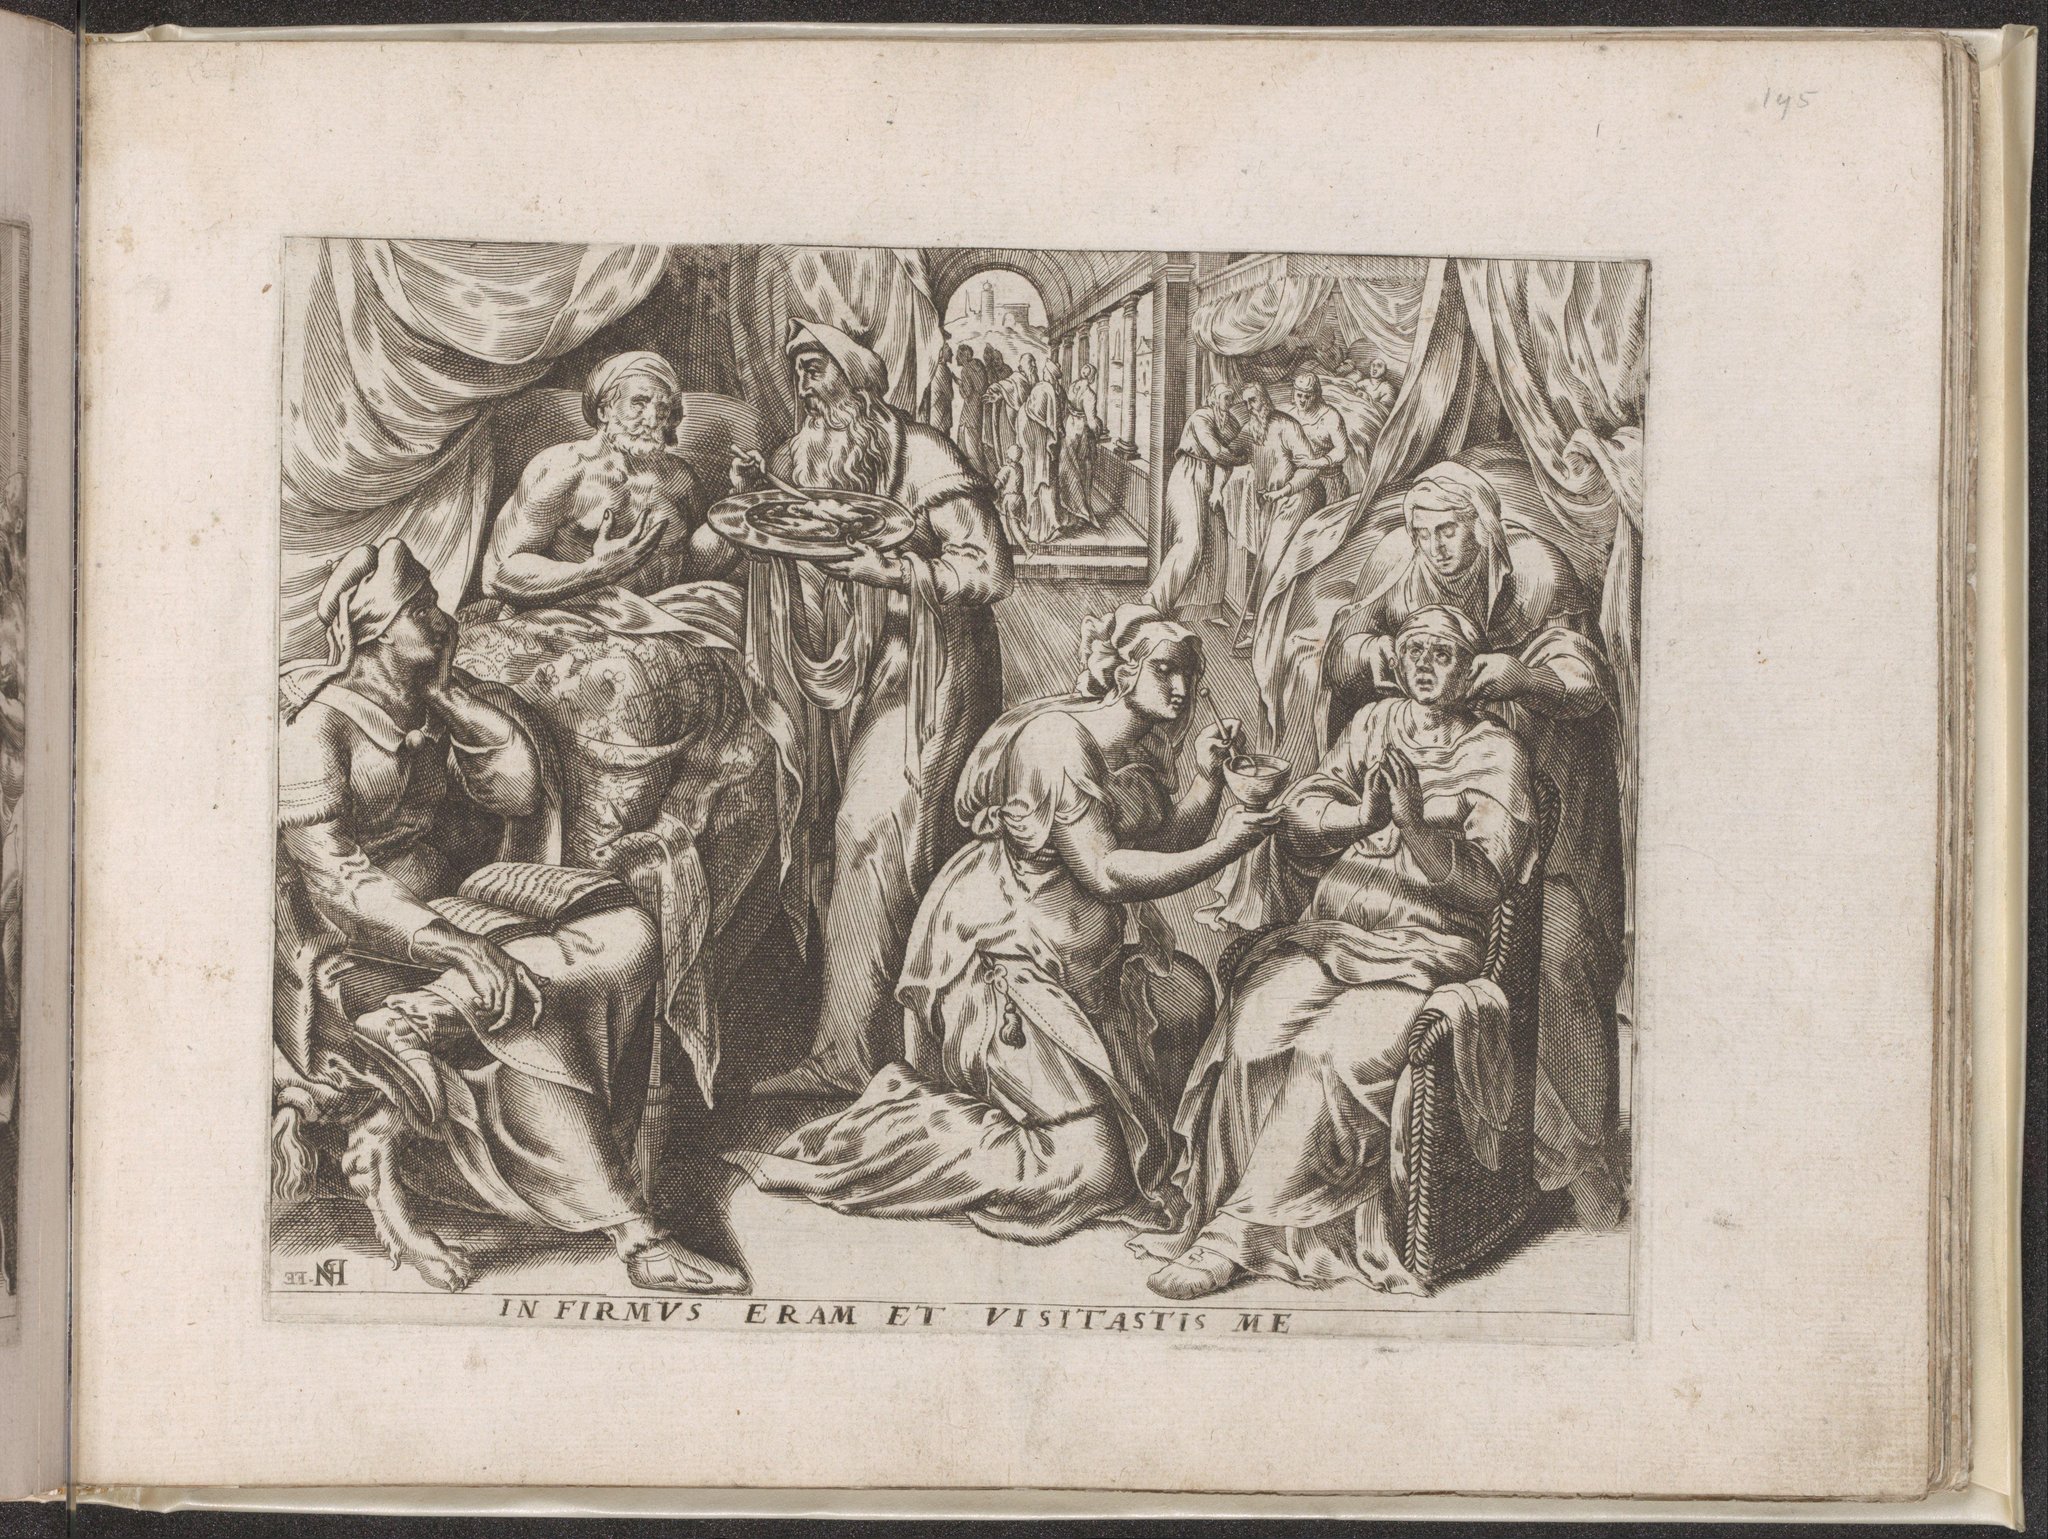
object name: album leaf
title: Bezoeken van de zieken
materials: paper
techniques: engraving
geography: antwerp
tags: hospital, visiting the sick, 'aeger curatur' ~ one of the (seven) acts of mercy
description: Het bezoeken en verzorgen van de zieken. In een gang met aan weerszijden bedden liggen de zieken. Links wordt een zieke voedsel aangeboden. Linksvoor zit een man met een boek op zijn schoot. Rechts zorgen twee vrouwen voor een zieke vrouw, die op een stoel zit. Onder de voorstelling een verklarende tekst in het Latijn. Deze prent maakt deel uit van een album.